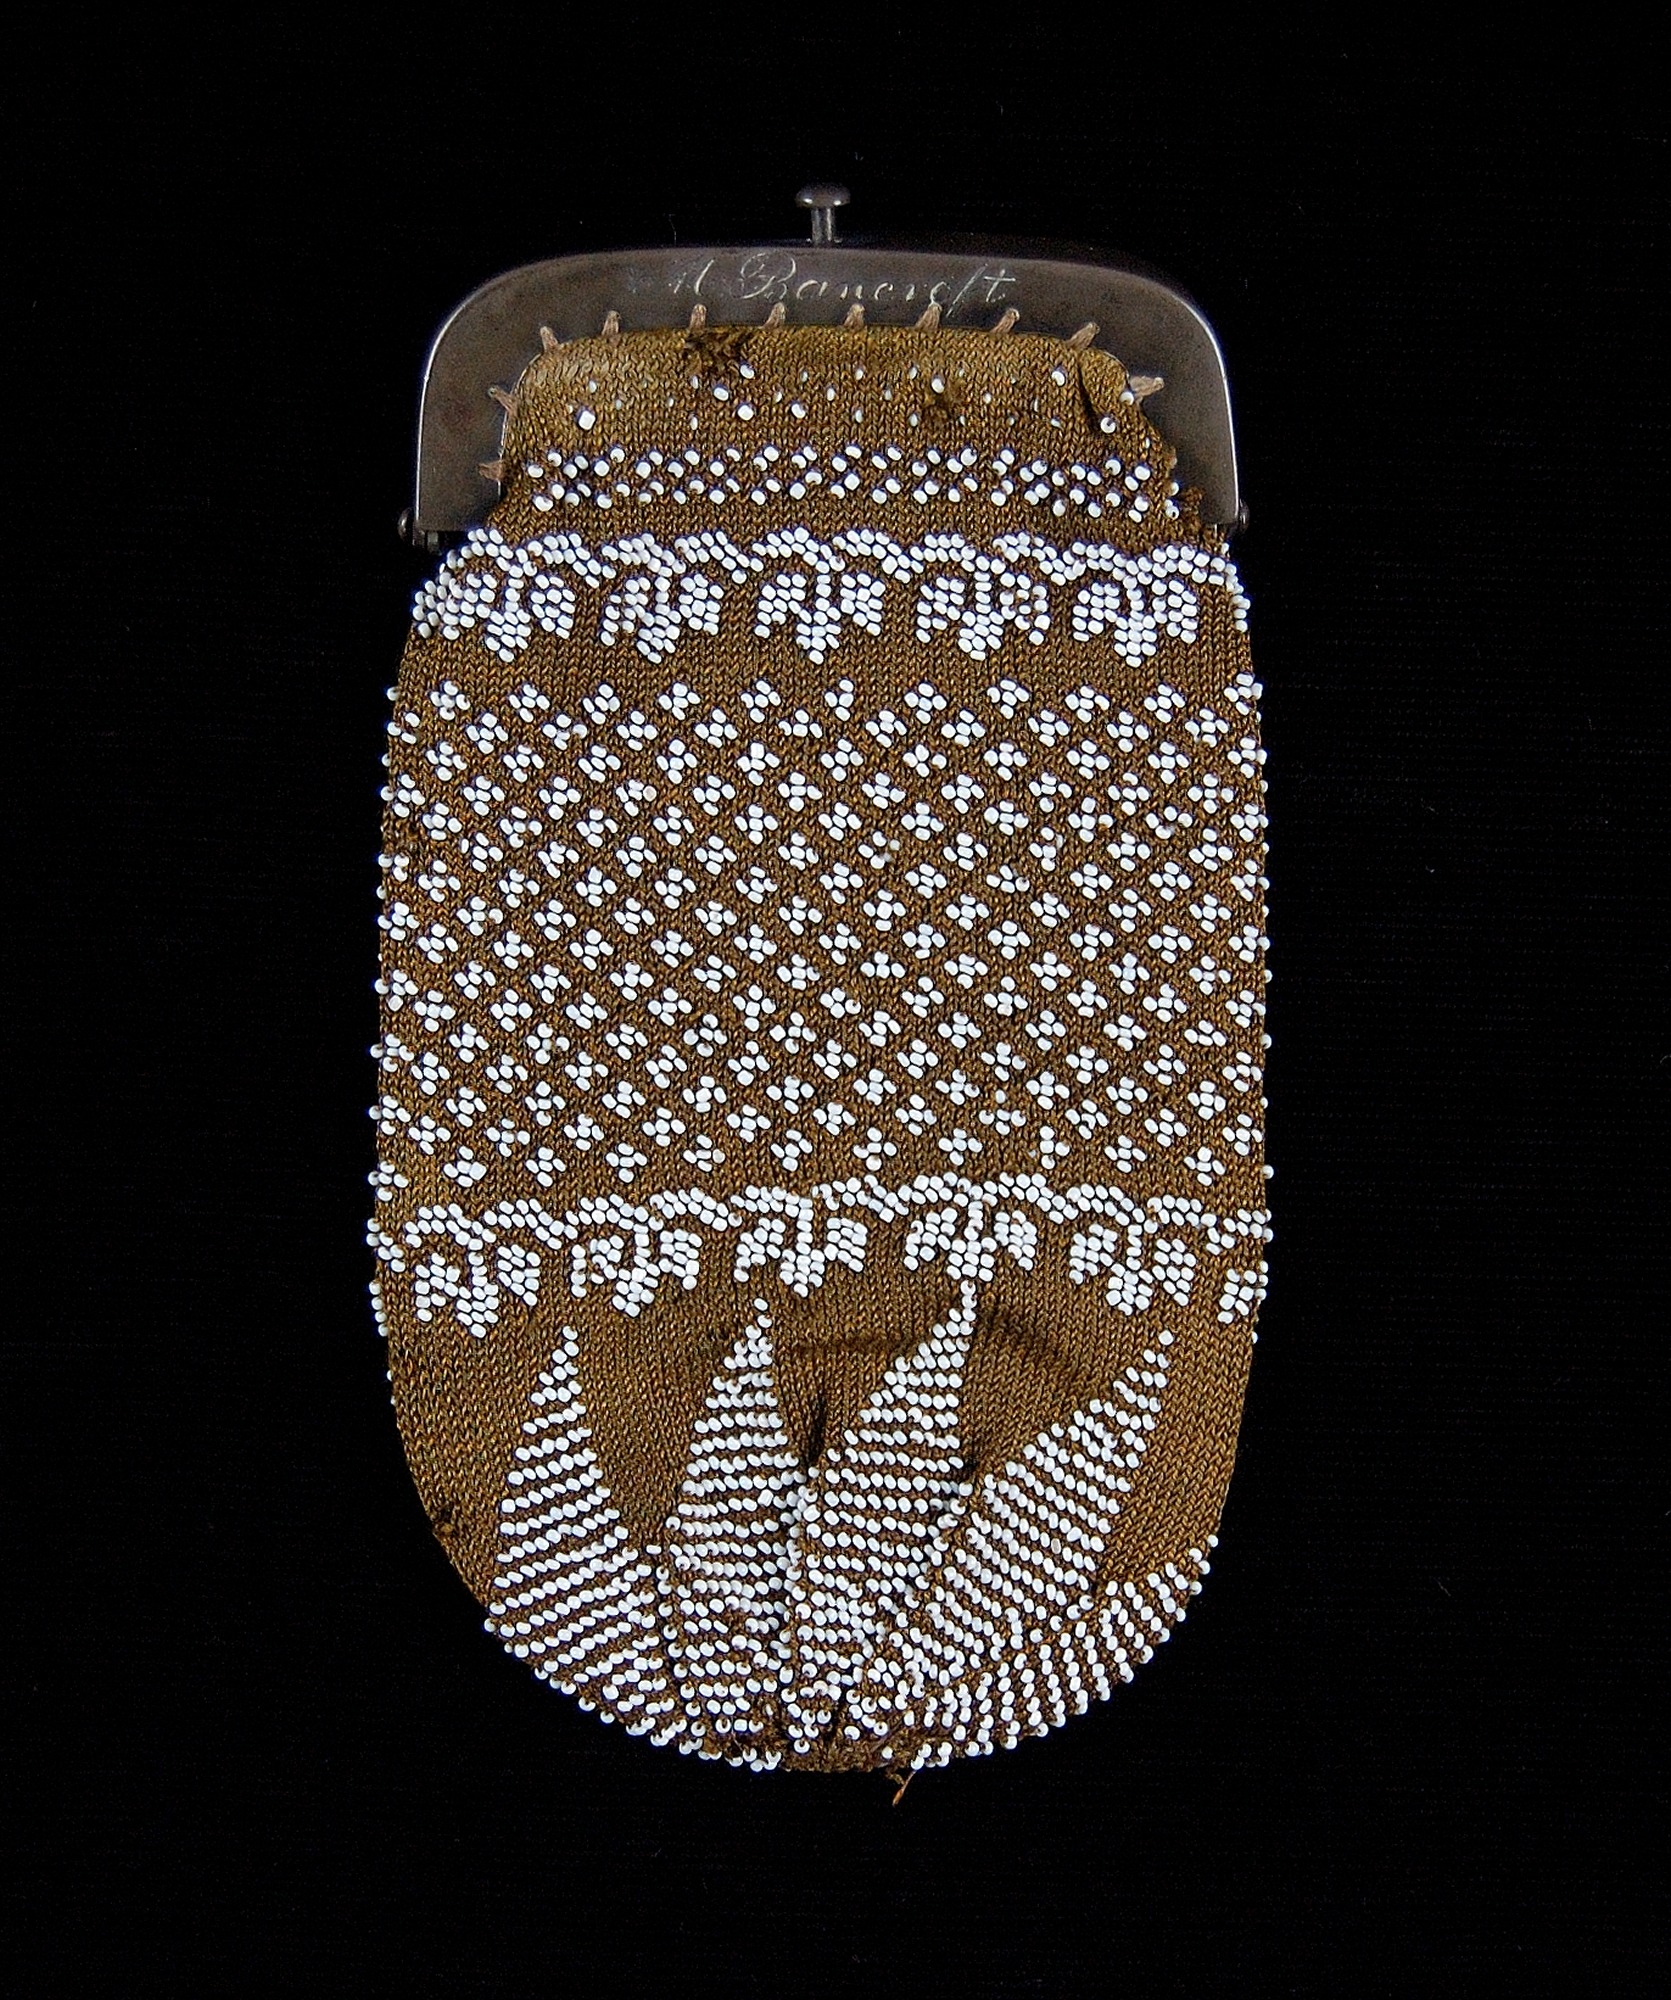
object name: coin purse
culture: american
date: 1820-1840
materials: glass, leather, metal, silk